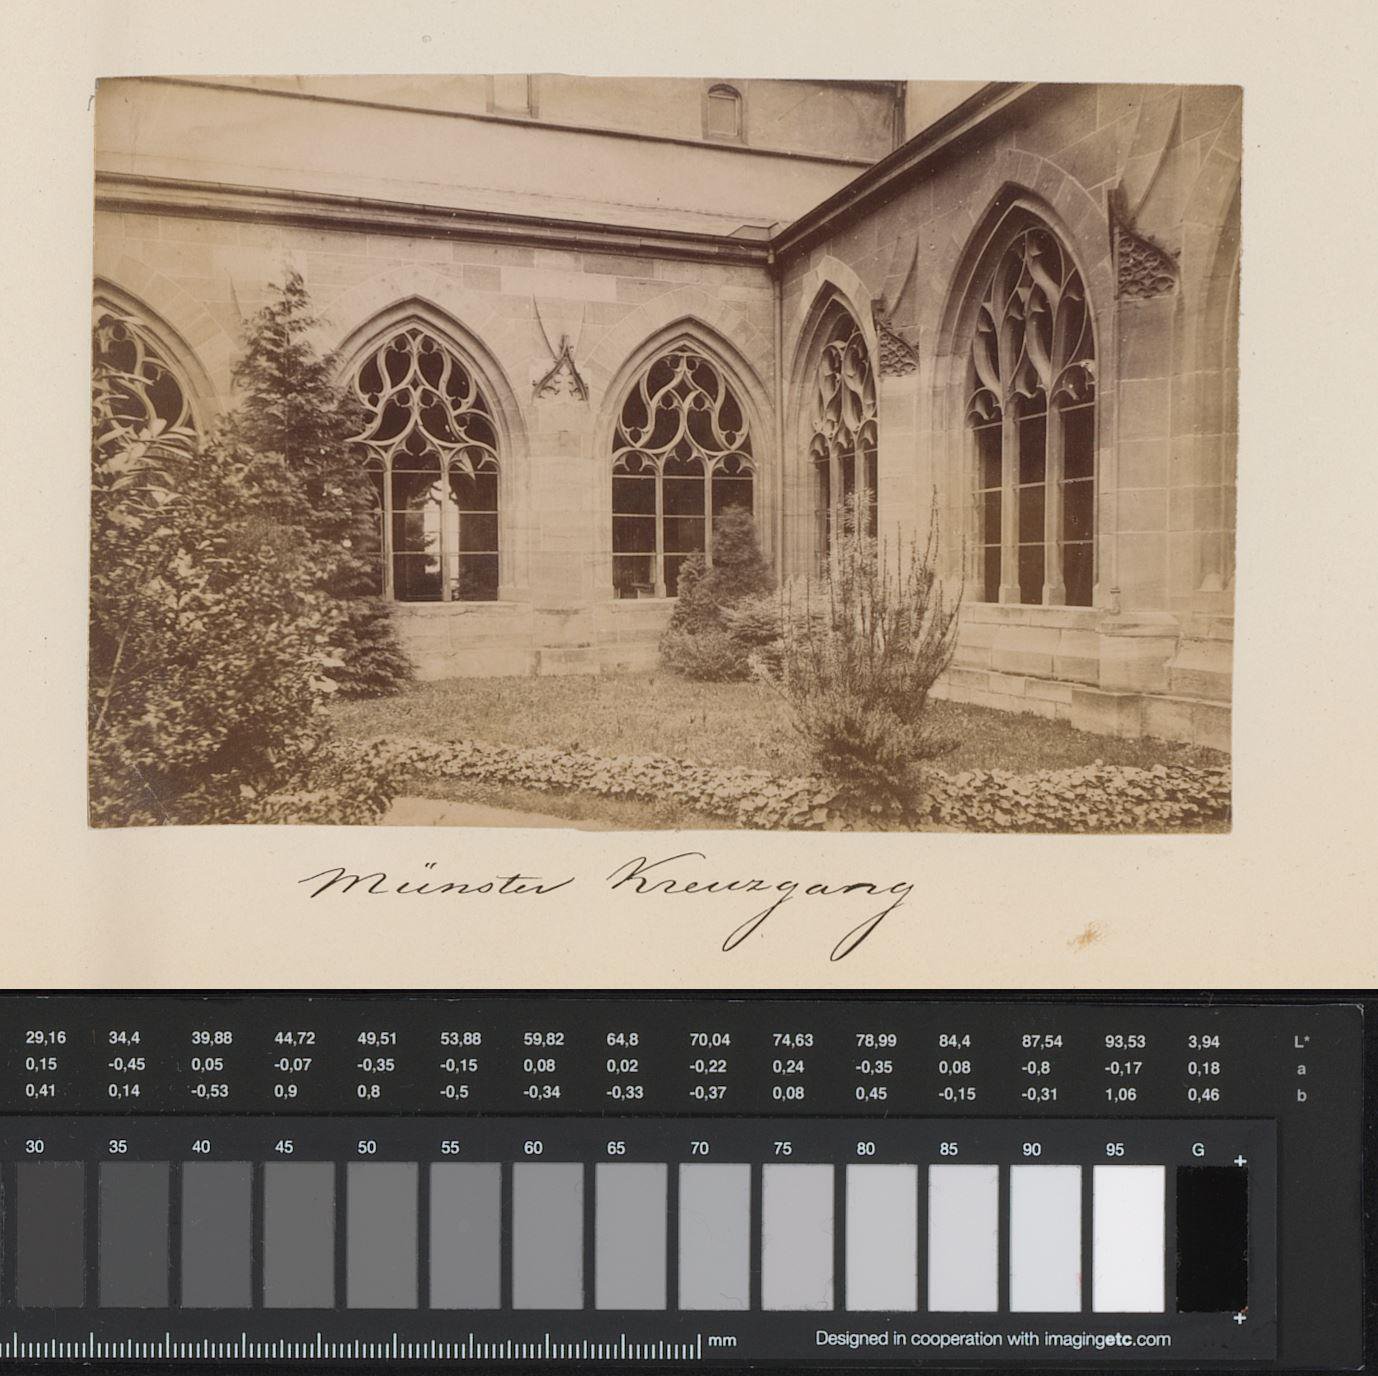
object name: album leaf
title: Kloostergang van de Munster van Bazel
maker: Anonymous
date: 1880-1900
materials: photographic support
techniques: albumen print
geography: basel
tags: cloisters ~ monastery